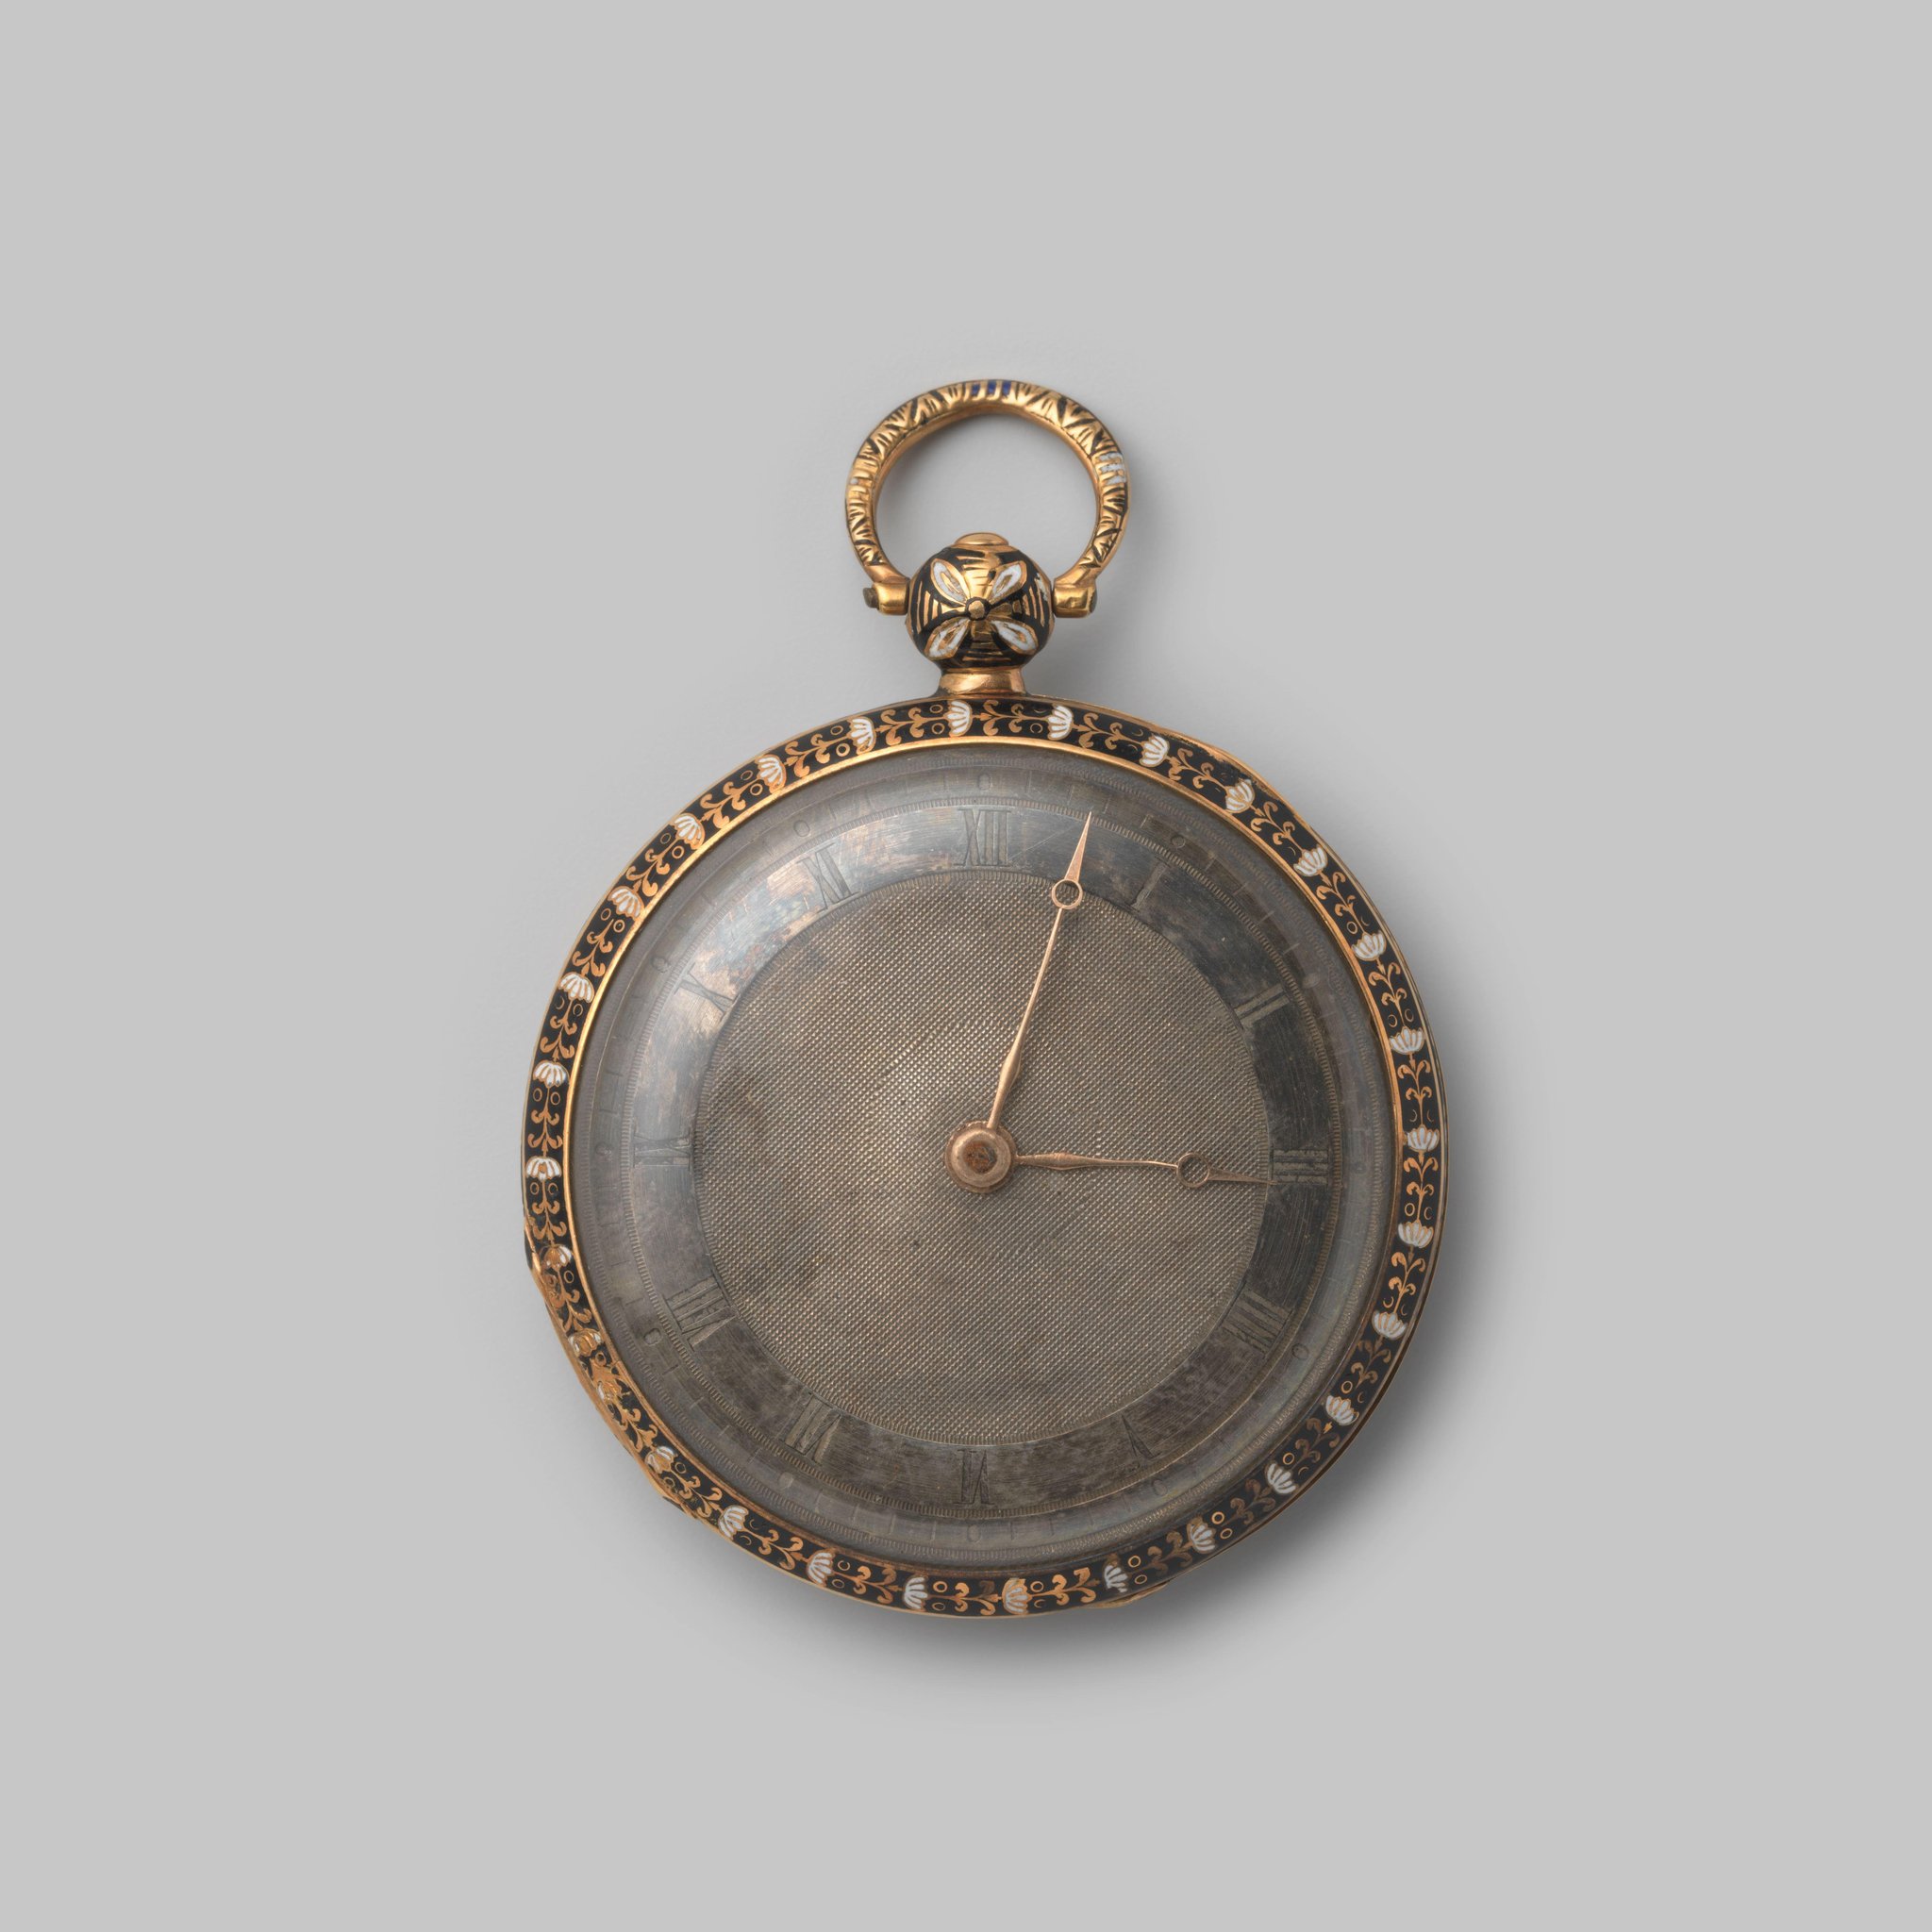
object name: wrist watch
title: Horloge van goud met gearceerde zilveren wijzerplaat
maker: Anonymous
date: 1840-1860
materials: gold, silver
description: Horloge van goud met gearceerde zilveren wijzerplaat. Achterbodem van de kast met graveerwerk versierd, waartussen email.